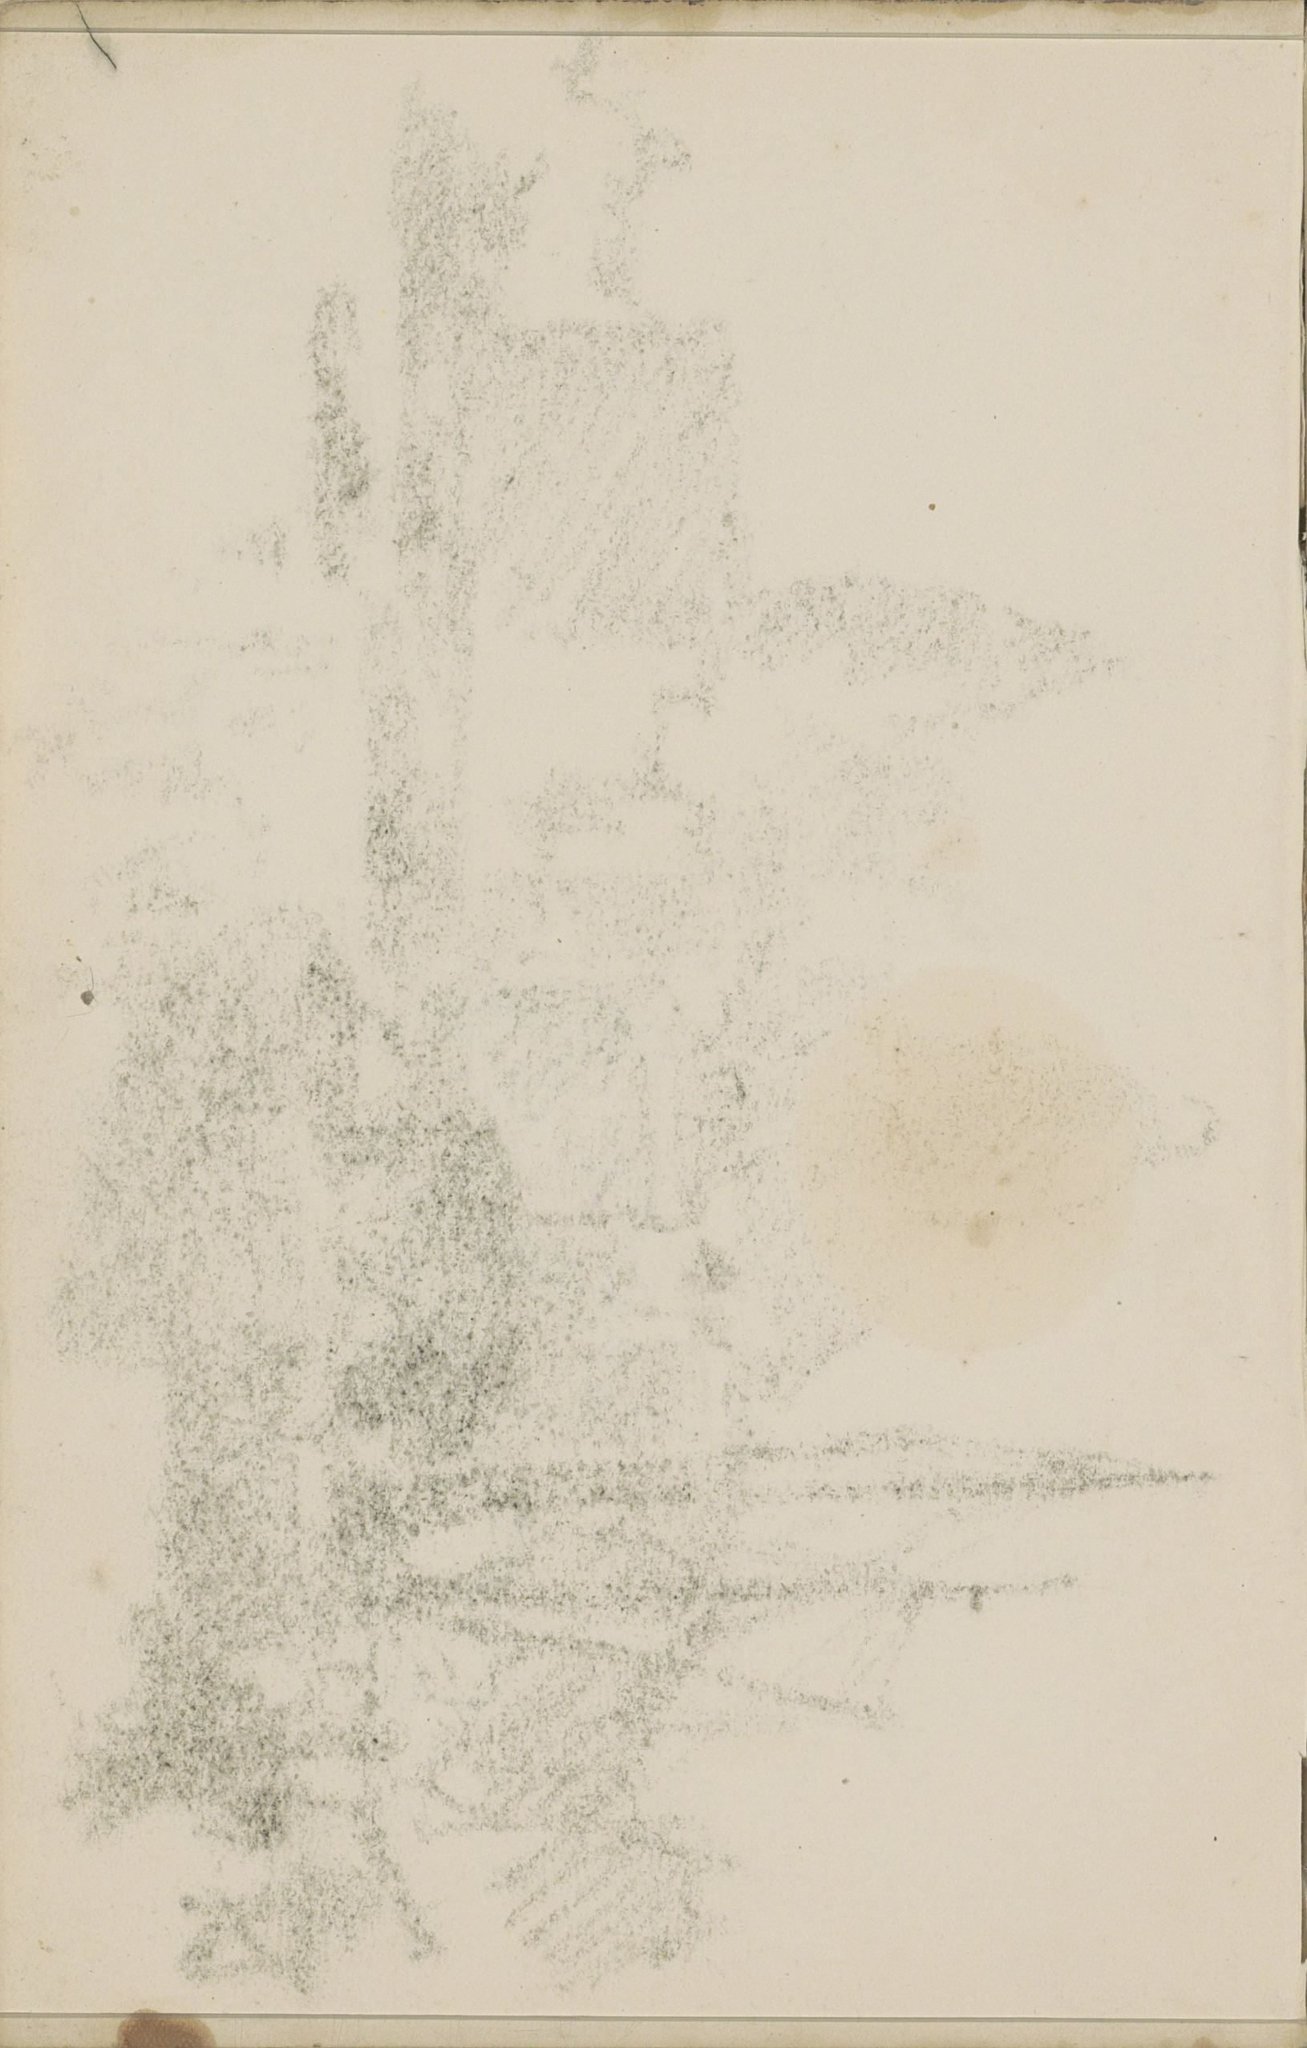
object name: sketchbook leaf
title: Abklatsch van de krijttekening op pagina 26 recto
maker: cornelis vreedenburgh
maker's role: draughtsman, print maker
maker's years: 1880-1946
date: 1890-1946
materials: paper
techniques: printmaking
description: Blad 25 verso uit een schetsboek met 45 bladen.